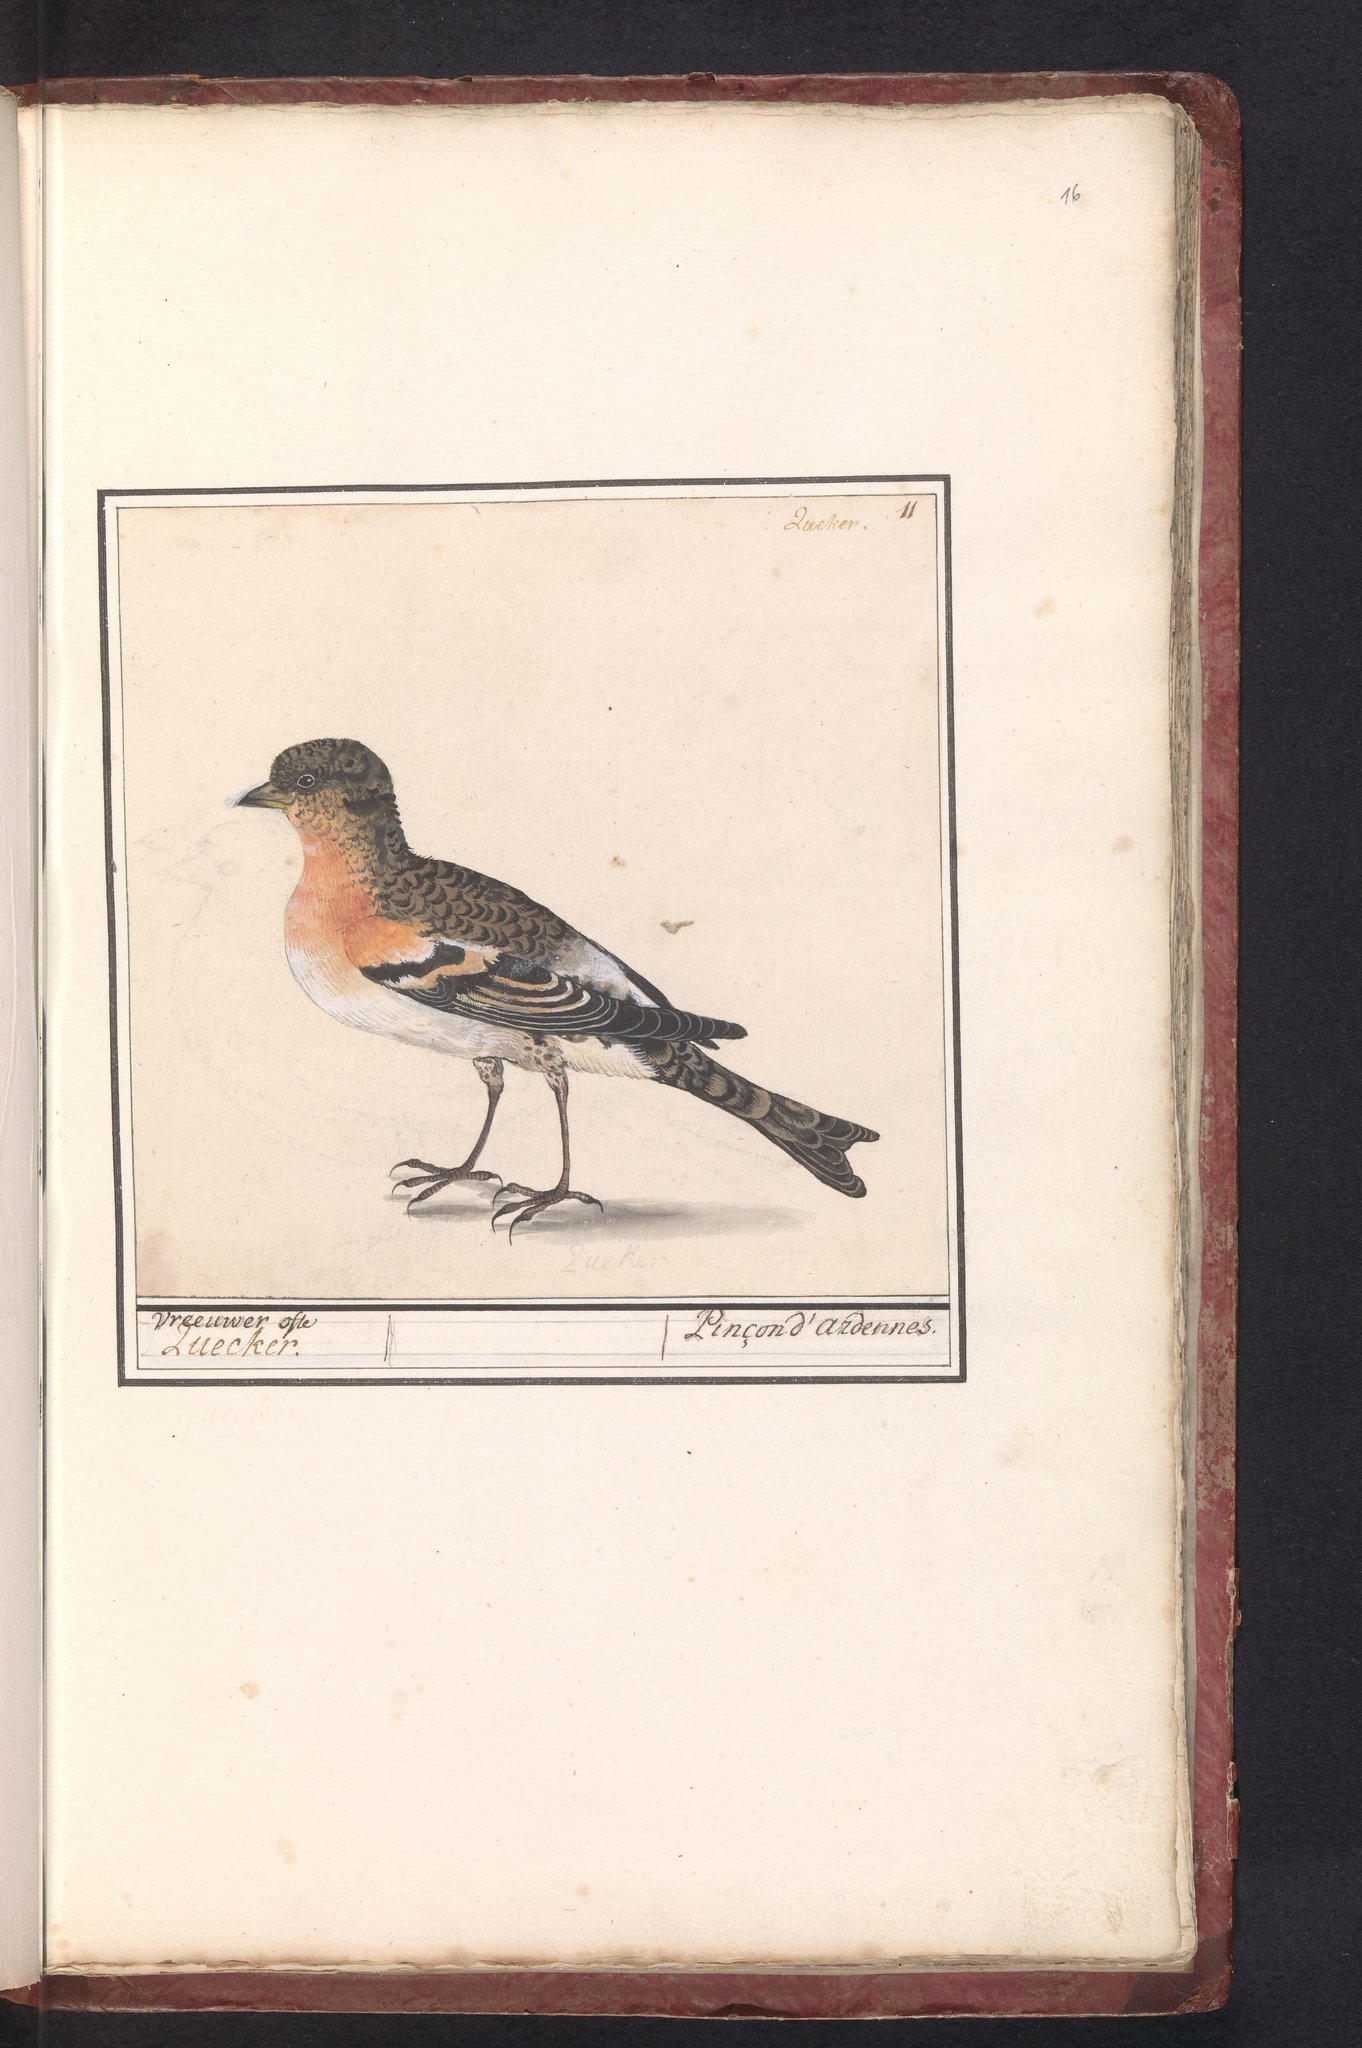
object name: drawing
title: Keep (Fringilla montifringilla)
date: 1596-1610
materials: paint, paper, pencil, watercolor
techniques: brush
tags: song-birds: brambling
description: Keep. Genummerd rechtsboven: 11. Onderdeel van het tweede album met tekeningen van vogels. Vierde van twaalf albums met tekeningen van dieren, vogels en planten bekend rond 1600, gemaakt in opdracht van keizer Rudolf II. Met toelichting in Nederlands, Latijn en Frans.